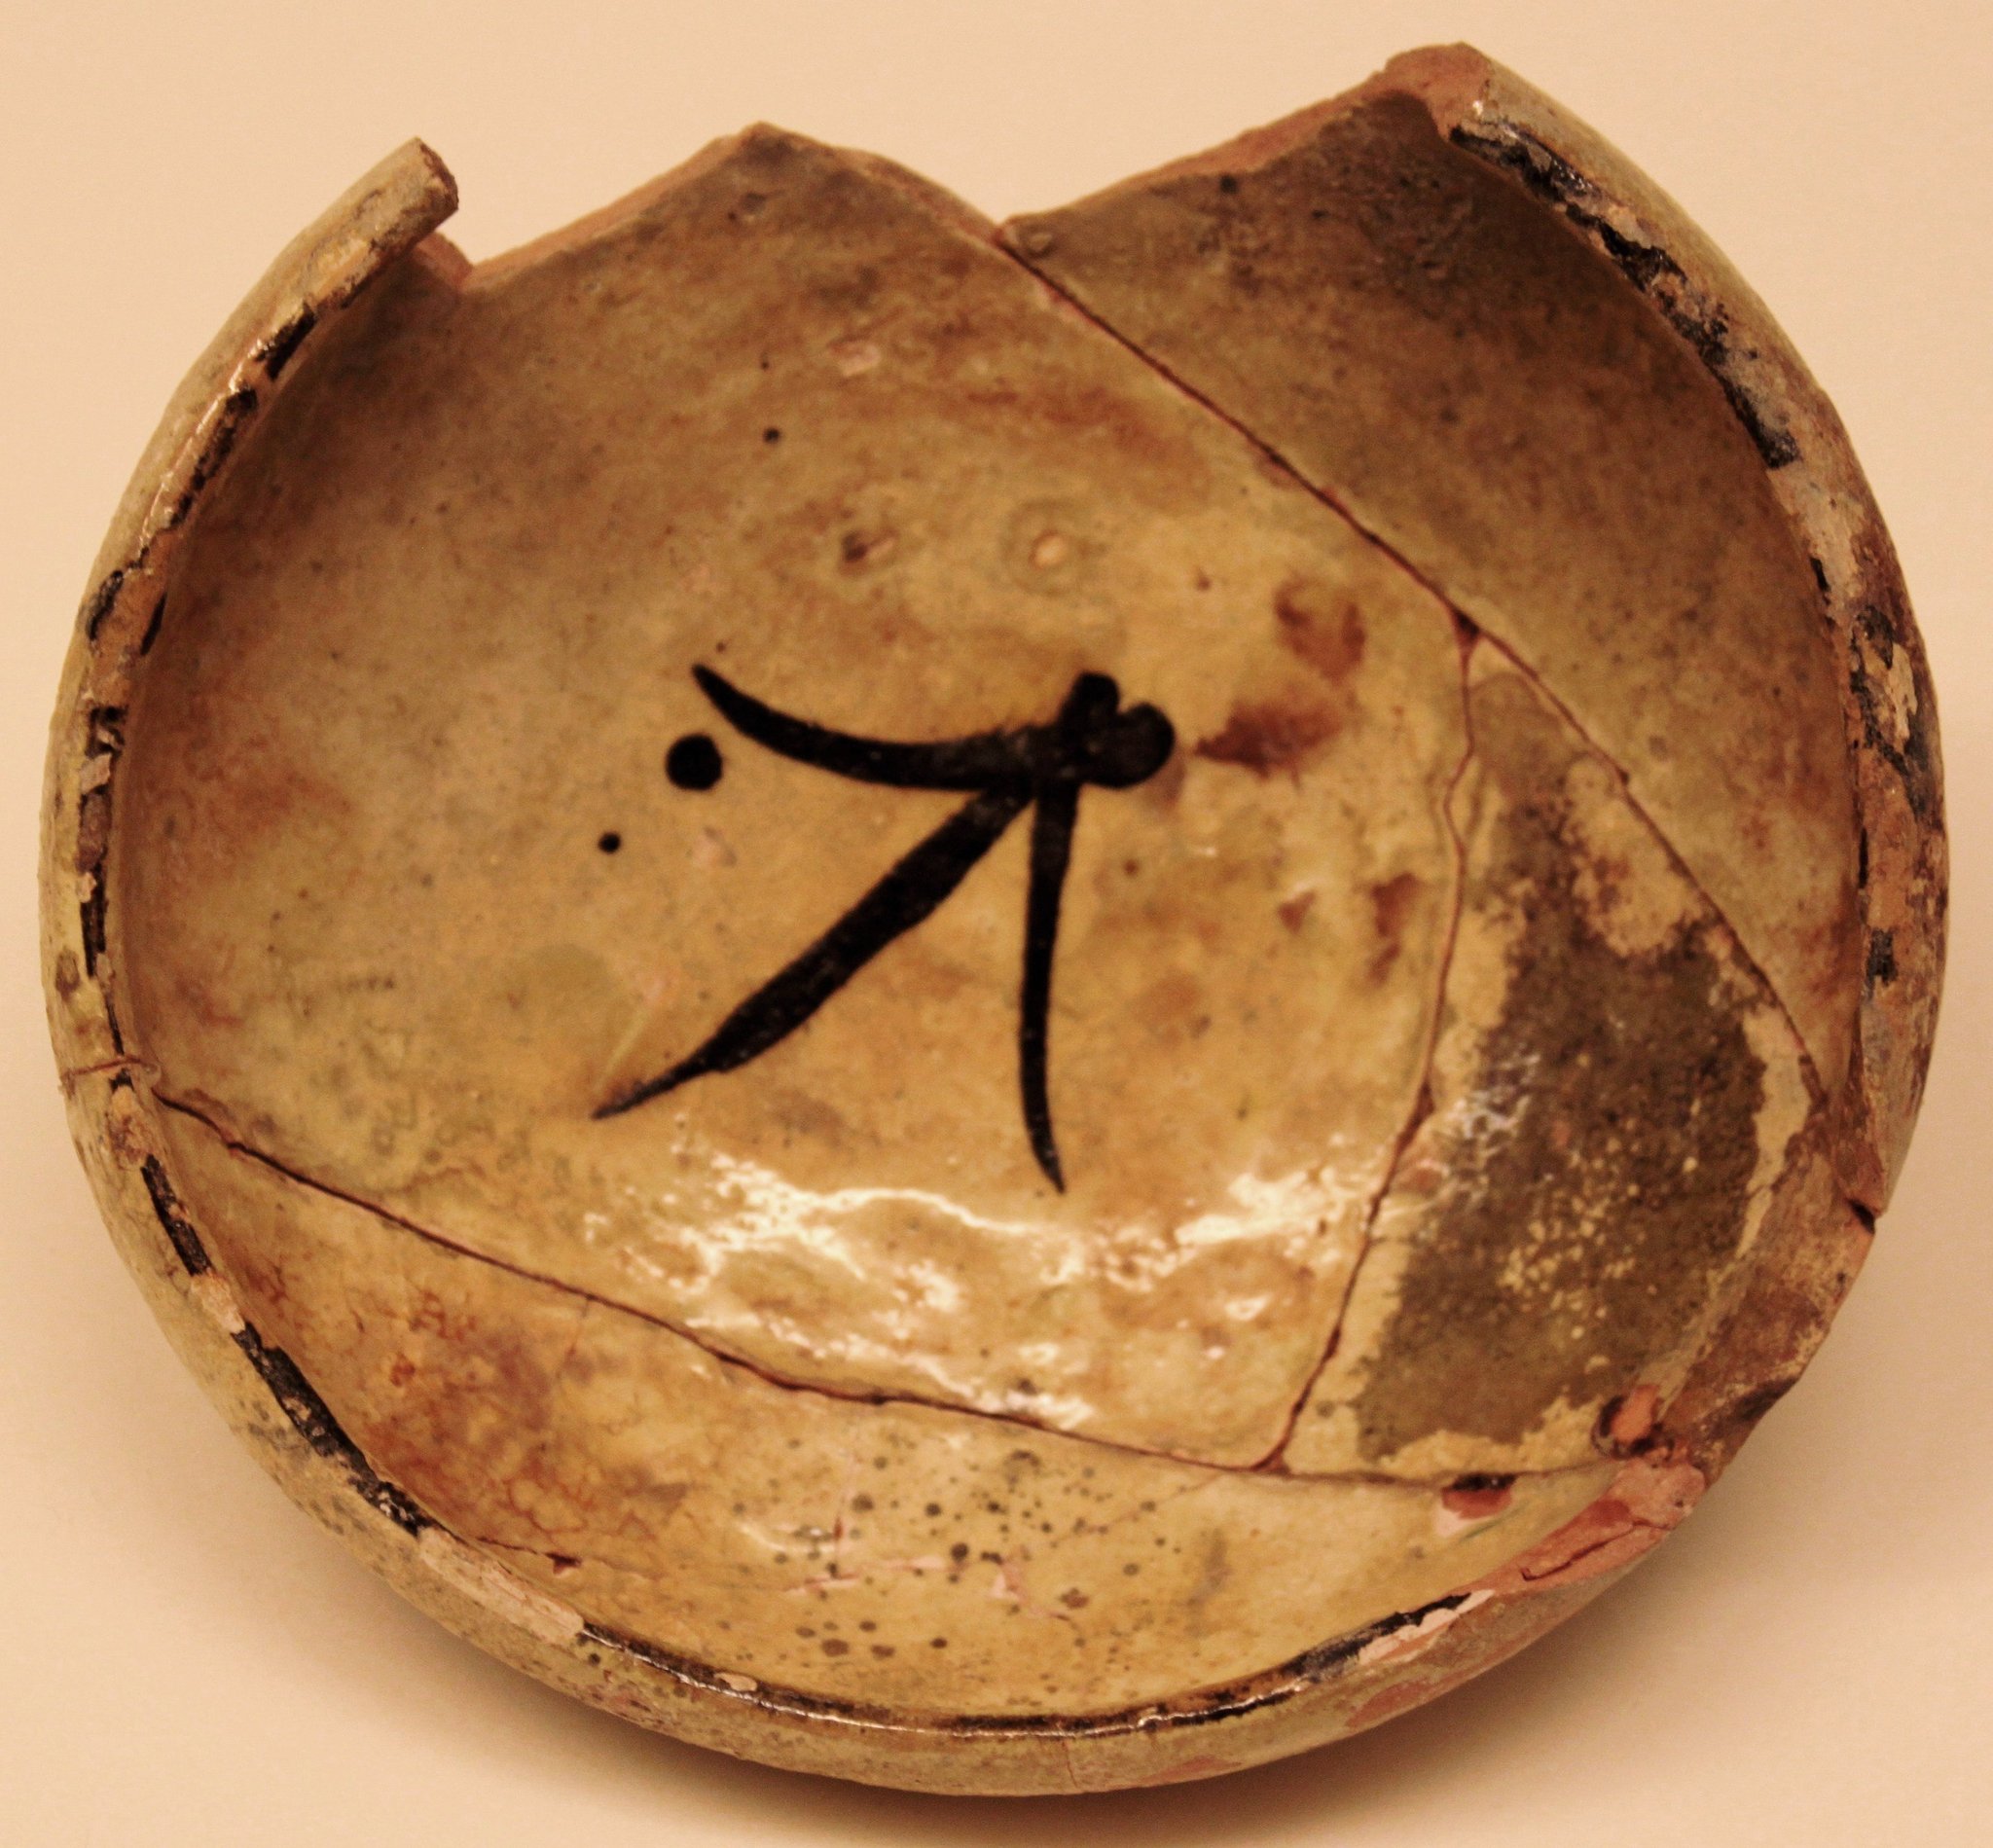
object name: bowl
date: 801-900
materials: earthenware, glaze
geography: iran